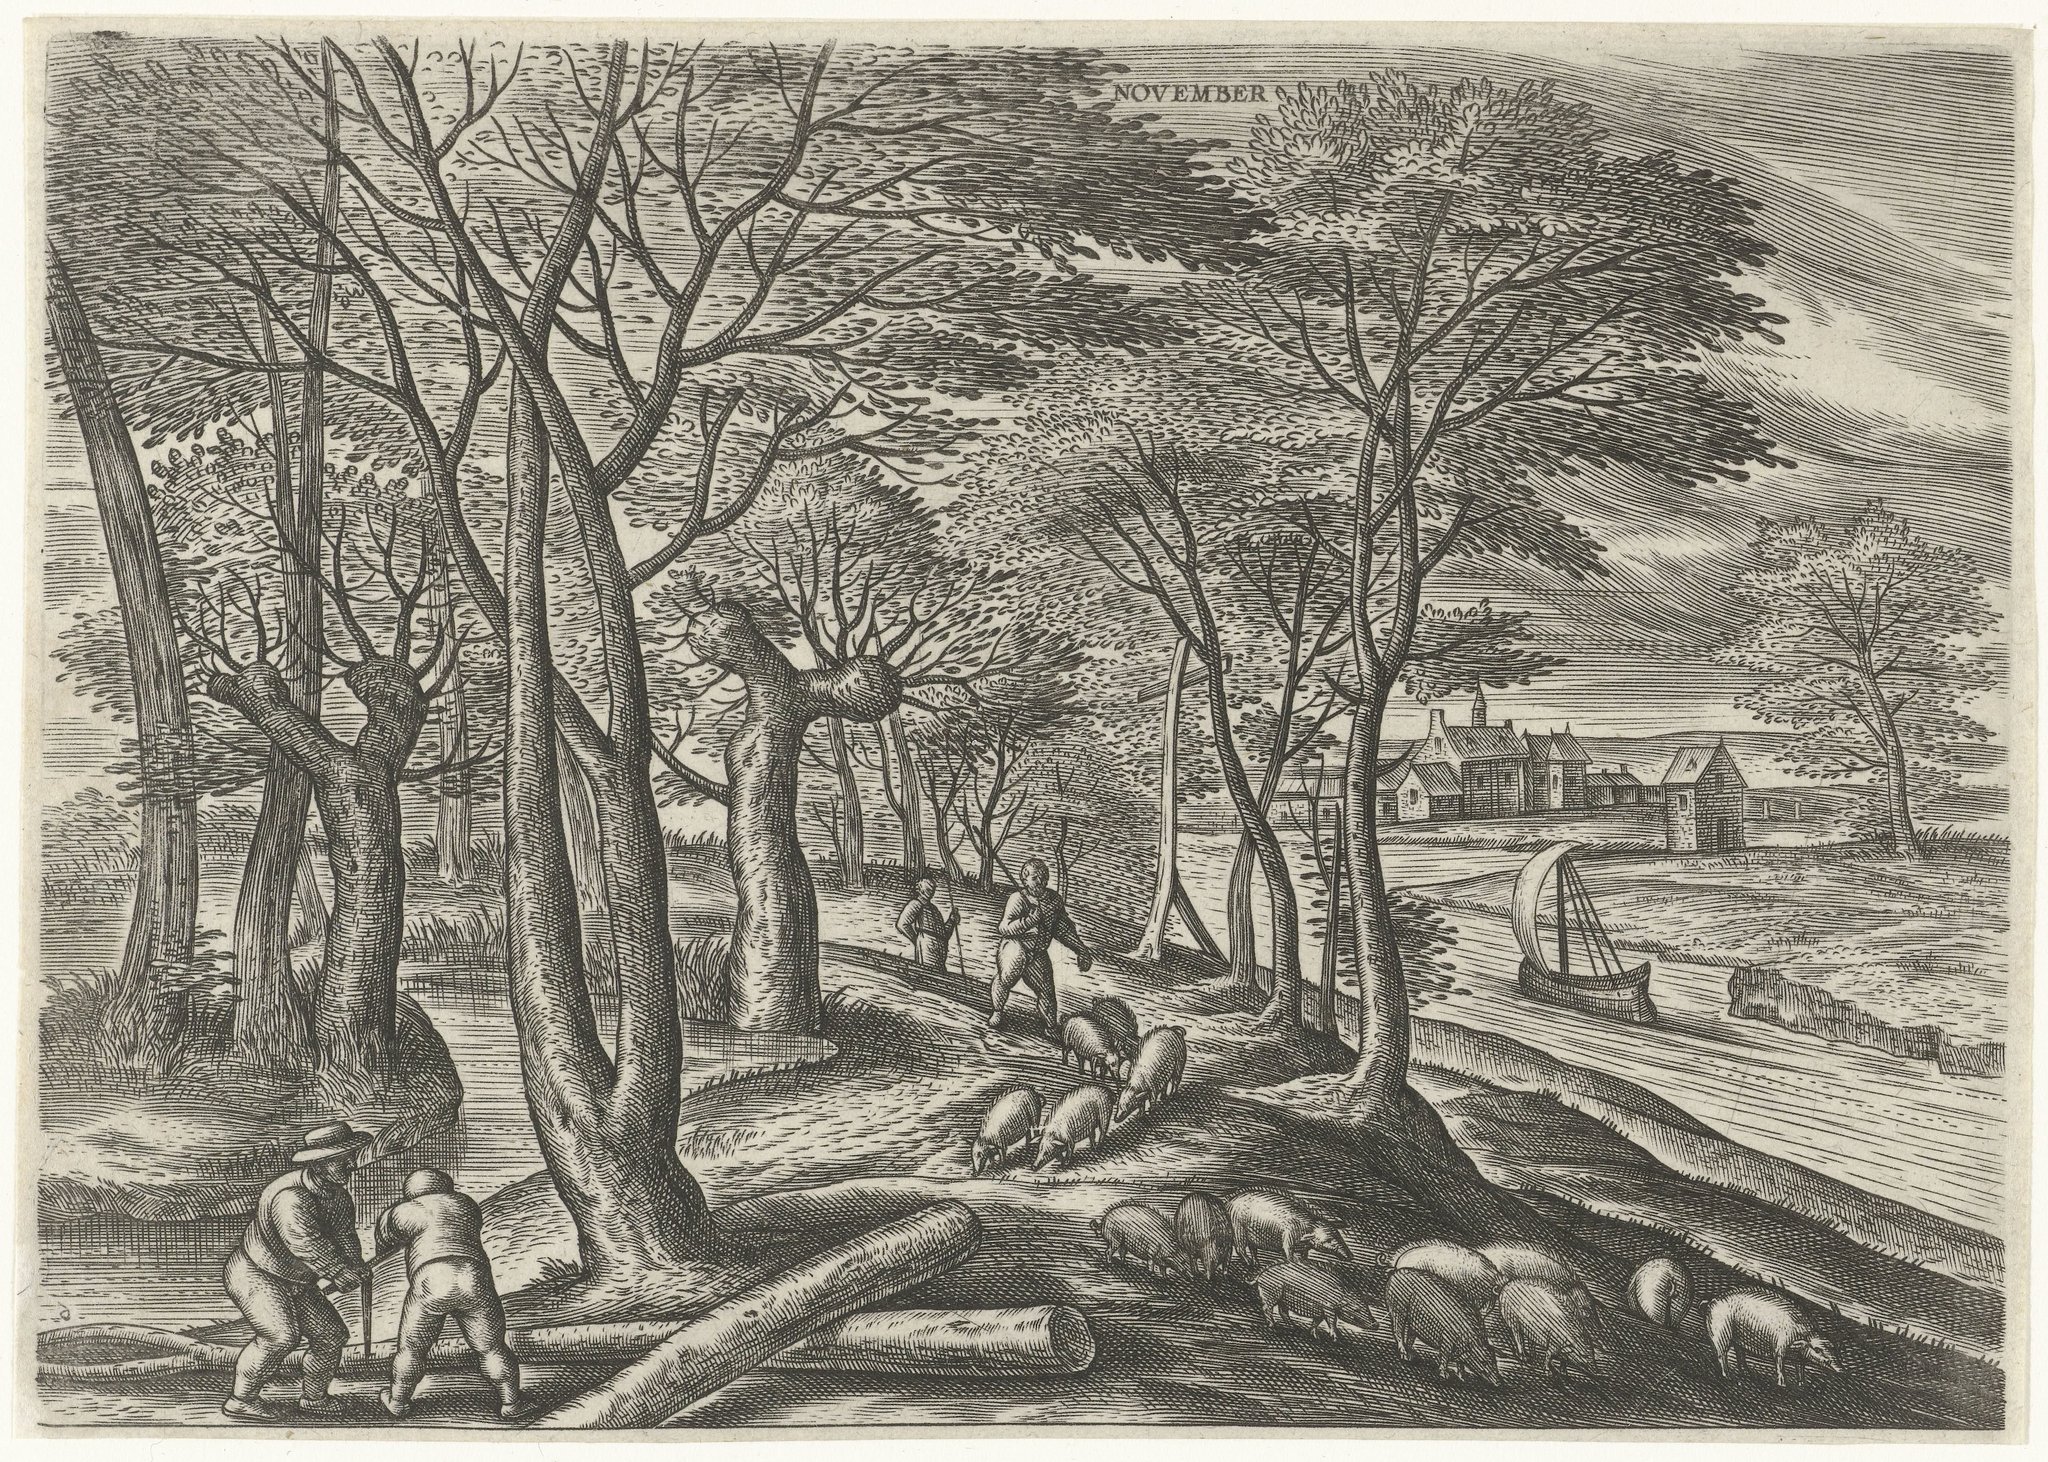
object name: print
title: November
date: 1560-1595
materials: paper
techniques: engraving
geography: antwerp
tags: november and its 'labours', driving pigs to the wood to eat acorns, sawing (industrial process)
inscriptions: collector's mark: Lugt 2228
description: Herfstlandschap met najaarstaferelen. November is de eikel- en slachtmaand. Op de voorgrond links zagen twee boeren een boom in twee. In het midden een herder die zijn varkens door het bos drijft, op zoek naar eikels voor de beesten. Deel van een serie van de twaalf maanden, waarbij elke maand wordt afgebeeld met de voor haar typerende menselijke activiteiten en haar klimatologische kenmerken.